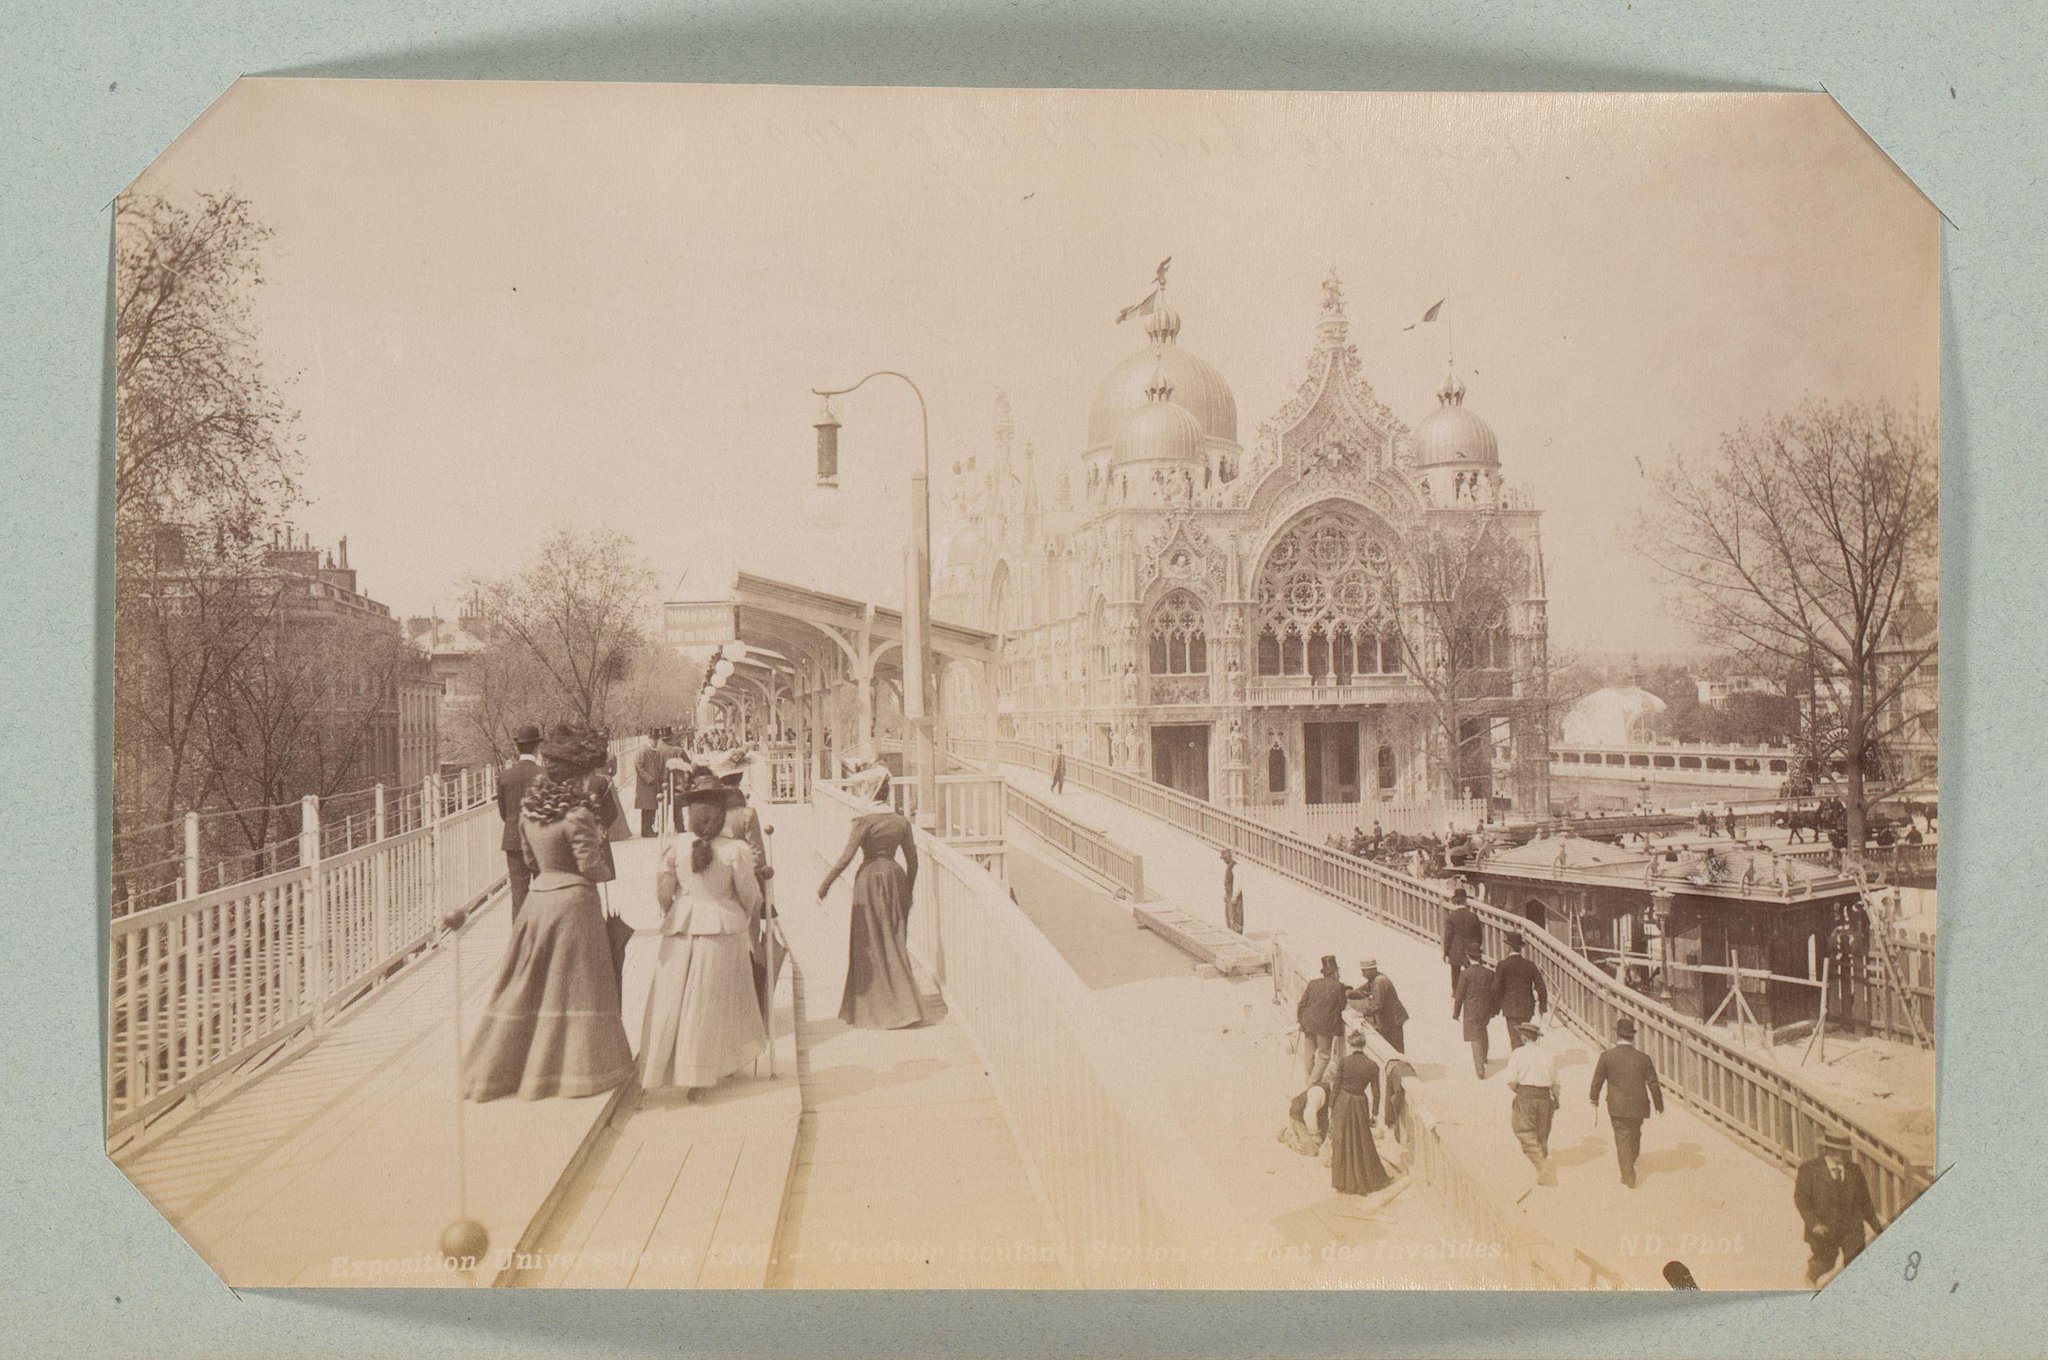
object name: album leaf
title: Loopband (trottoir roulant) als deel van de Rue de l'Avenir op de Wereldtentoonstelling van 1900, Parijs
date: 1900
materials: paper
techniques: albumen print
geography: paris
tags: world fair, world exhibition, street, paris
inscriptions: number: ‘936’, number: ‘66’, inscription: ‘verblijf te Parijs 10 Aug-25 Aug: 1900’, inscription: ‘ND Phot’